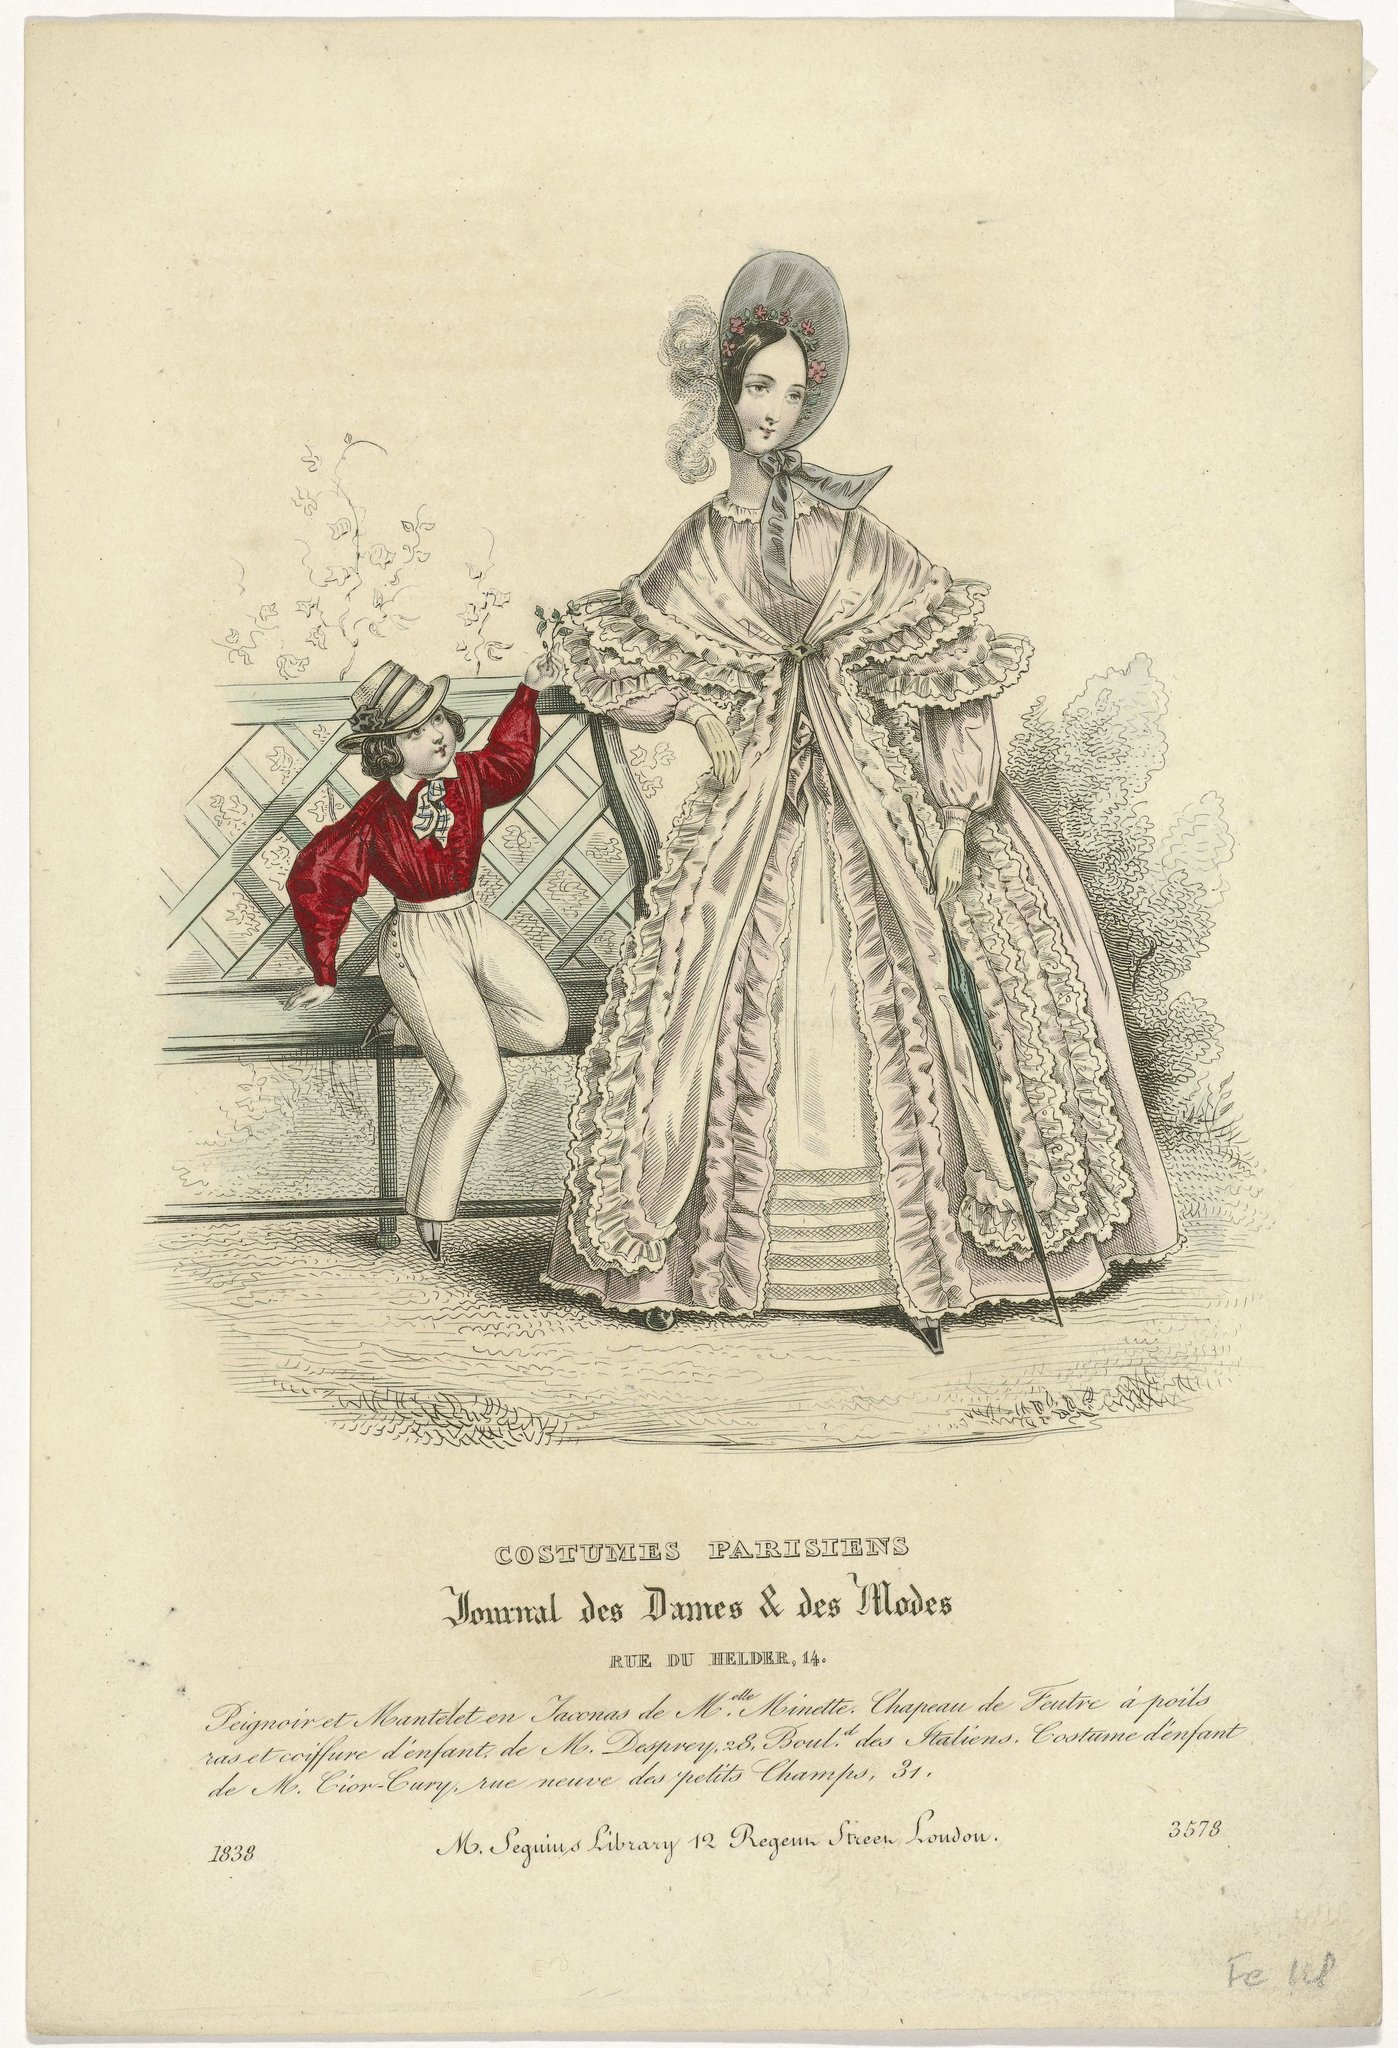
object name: fashion print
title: Journal des Dames et des Modes, Costumes Parisiens, 1838, (3578): Peignoir et Mantelet en Jaconas (...)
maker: Anonymous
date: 1838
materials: paper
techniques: engraving, hand coloring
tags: trousers, breeches (+ boys' clothes), shoes, sandals (+ boys' clothes), clothing for the upper part of the body (+ boys' clothes), head-gear (+ boys' clothes), neck-gear ~ clothing (+ boys' clothes), coat (housecoat) (+ women's clothes), clothing for the upper part of the body (mantelet) (+ women's clothes), head-gear (+ women's clothes), styles of hairdress, fashion plates, shoes, sandals (+ women's clothes), gloves, mittens, etc. (+ women's clothes), parasol, sunshade (+ women's clothes)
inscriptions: caption: ‘Peignoir et Mantelet en Jaconas de M'elle Minette. Chapeau de Feutre à poils ras et coiffure d'enfant, de M. Desprey, 28, Boul.d des Italiens. Costume d'enfant de M. Cior-Cury, rue neuve des petits Champs, 31.’, address: ‘Rue du Helder, 14. / M. Seguin's Library 12 Regent Street London.’, title: ‘Costumes Parisiens / Journal des Dames & des Modes’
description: Een vrouw en jongen bij een tuinbank. De vrouw draagt een 'peignoir' en kleine schoudermantel van 'jaconas' (fijne katoen) . Hoed van vilt, van M. Desprey. Verdere accessoires: handschoenen, parasol, schoen met vierkante neus. De jongen draagt kinderkleding van M. Cior-Cury. 'Coiffure' van M. Desprey. De prent maakt deel uit van het modetijdschrift Journal des Dames et des Modes, Parijs, 1797-1839.